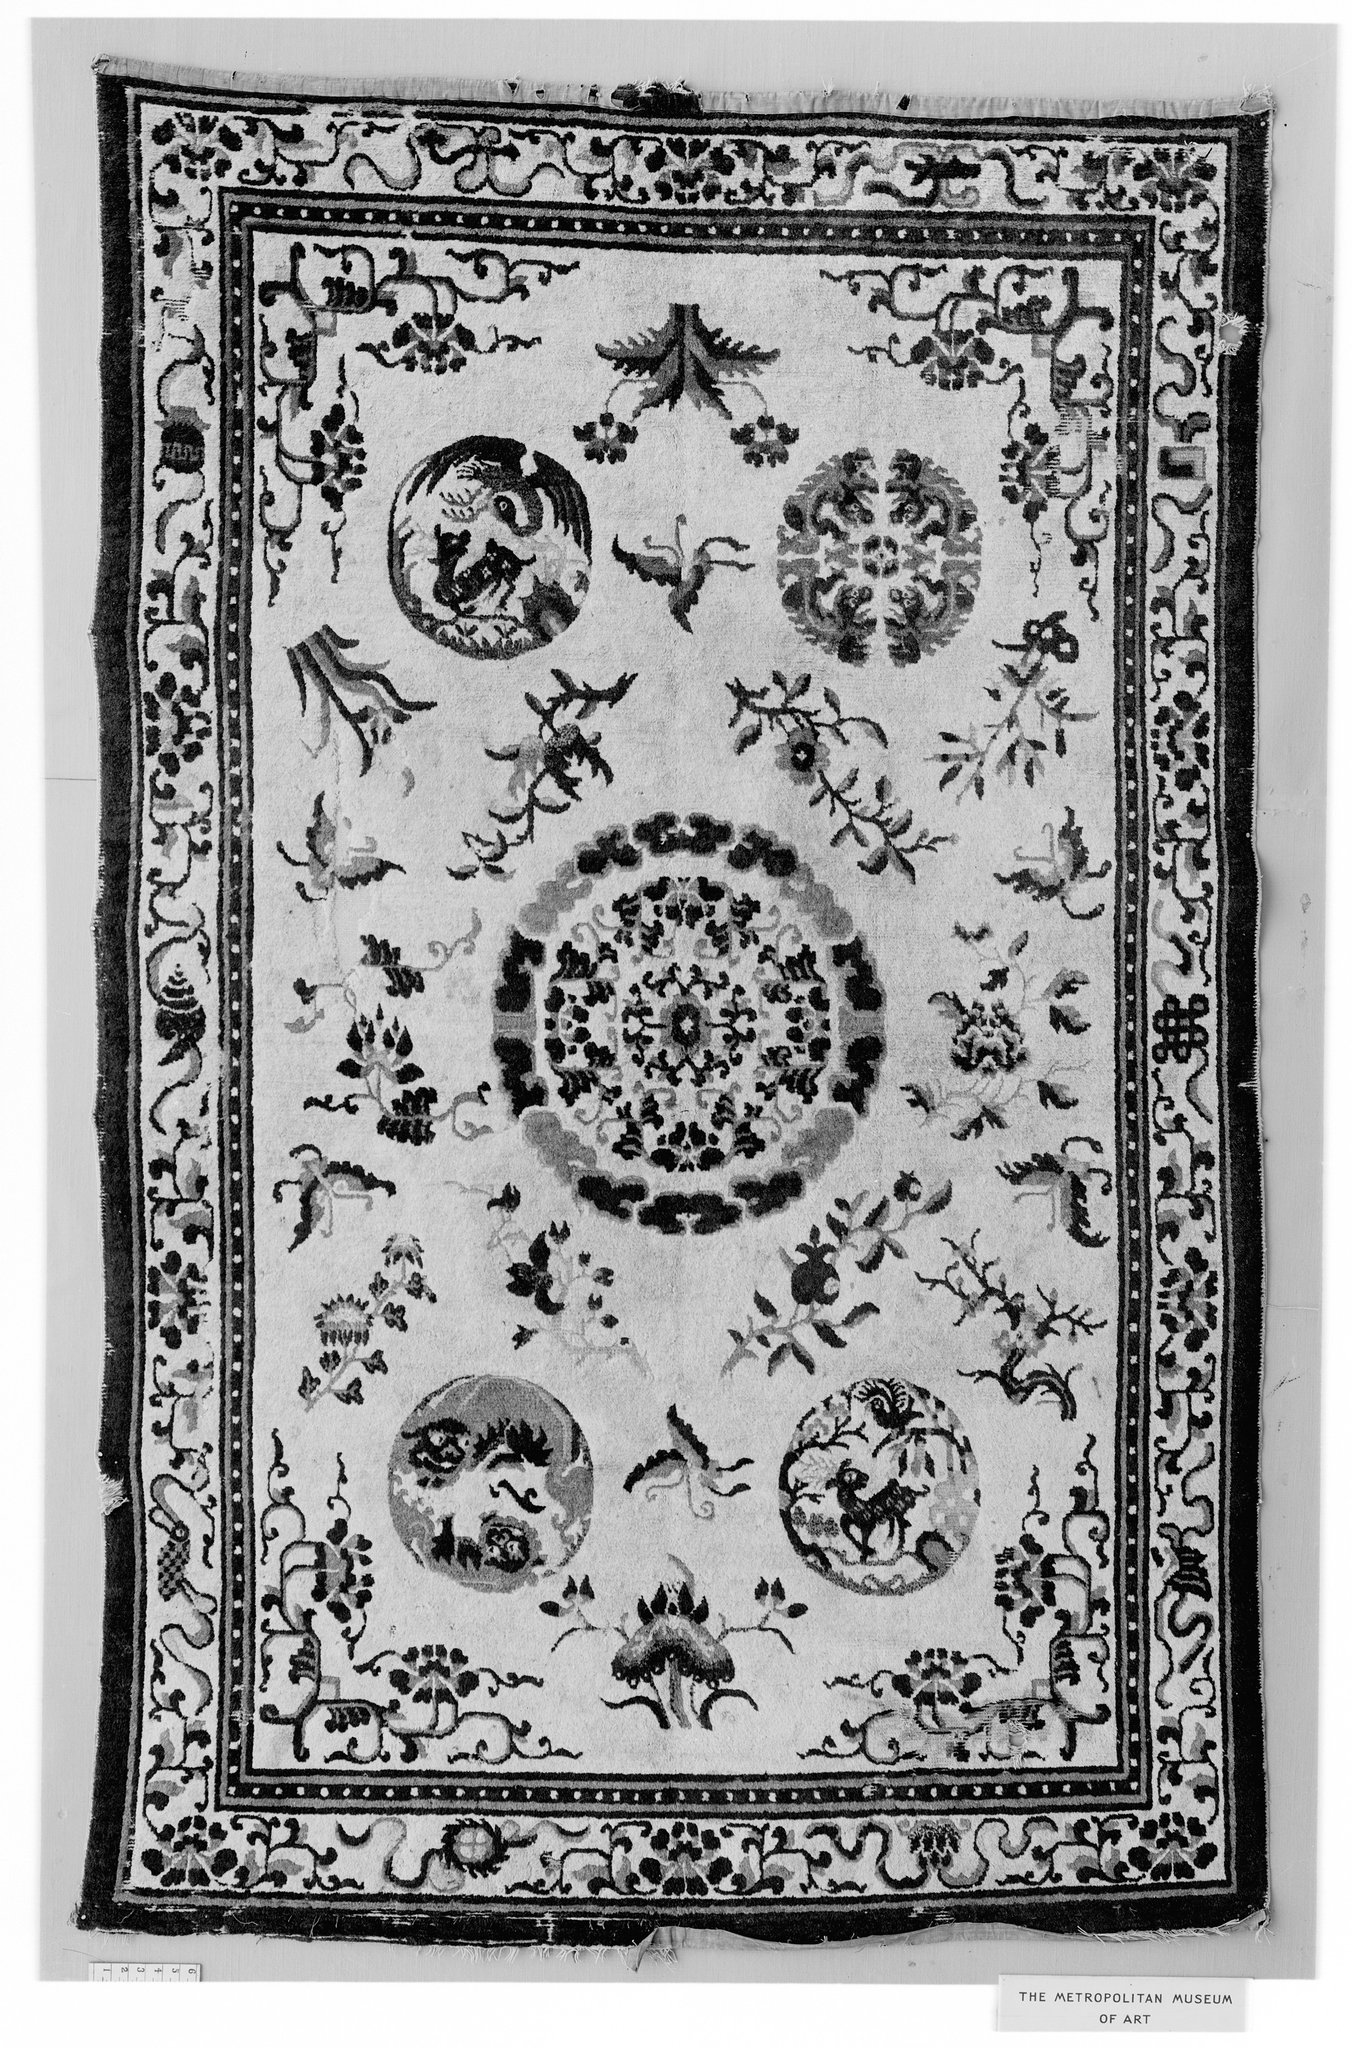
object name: rug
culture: chinese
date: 1801-1900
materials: cotton, wool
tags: dragons,deer,butterflies,lions